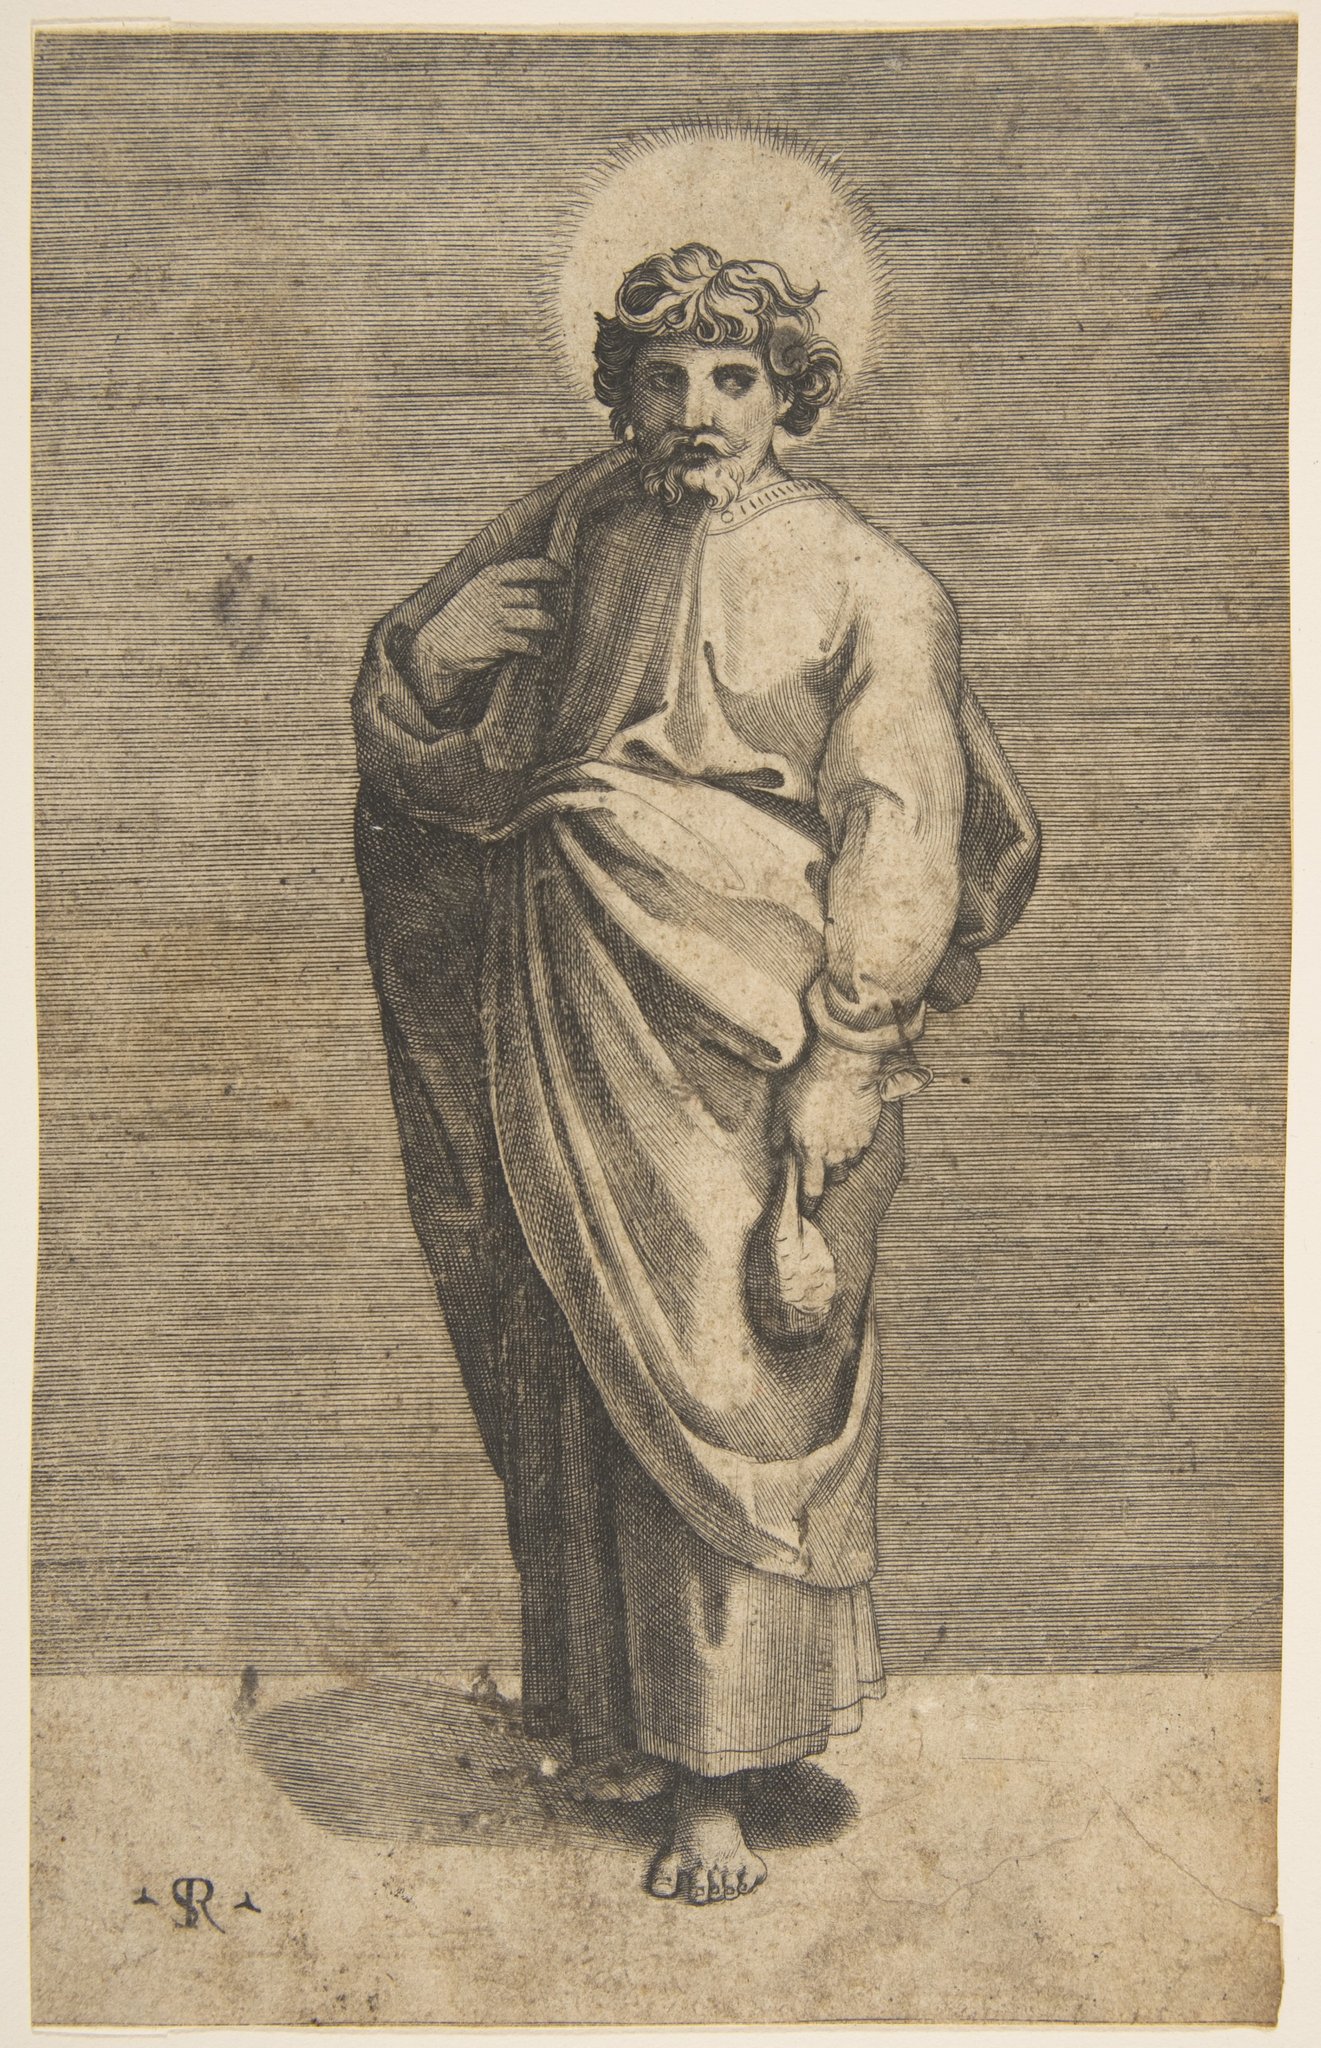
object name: print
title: Saint Matthew holding a pouch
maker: marco dente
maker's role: artist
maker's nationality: italian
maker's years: 1515-1527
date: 1515-1527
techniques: engraving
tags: saint matthew